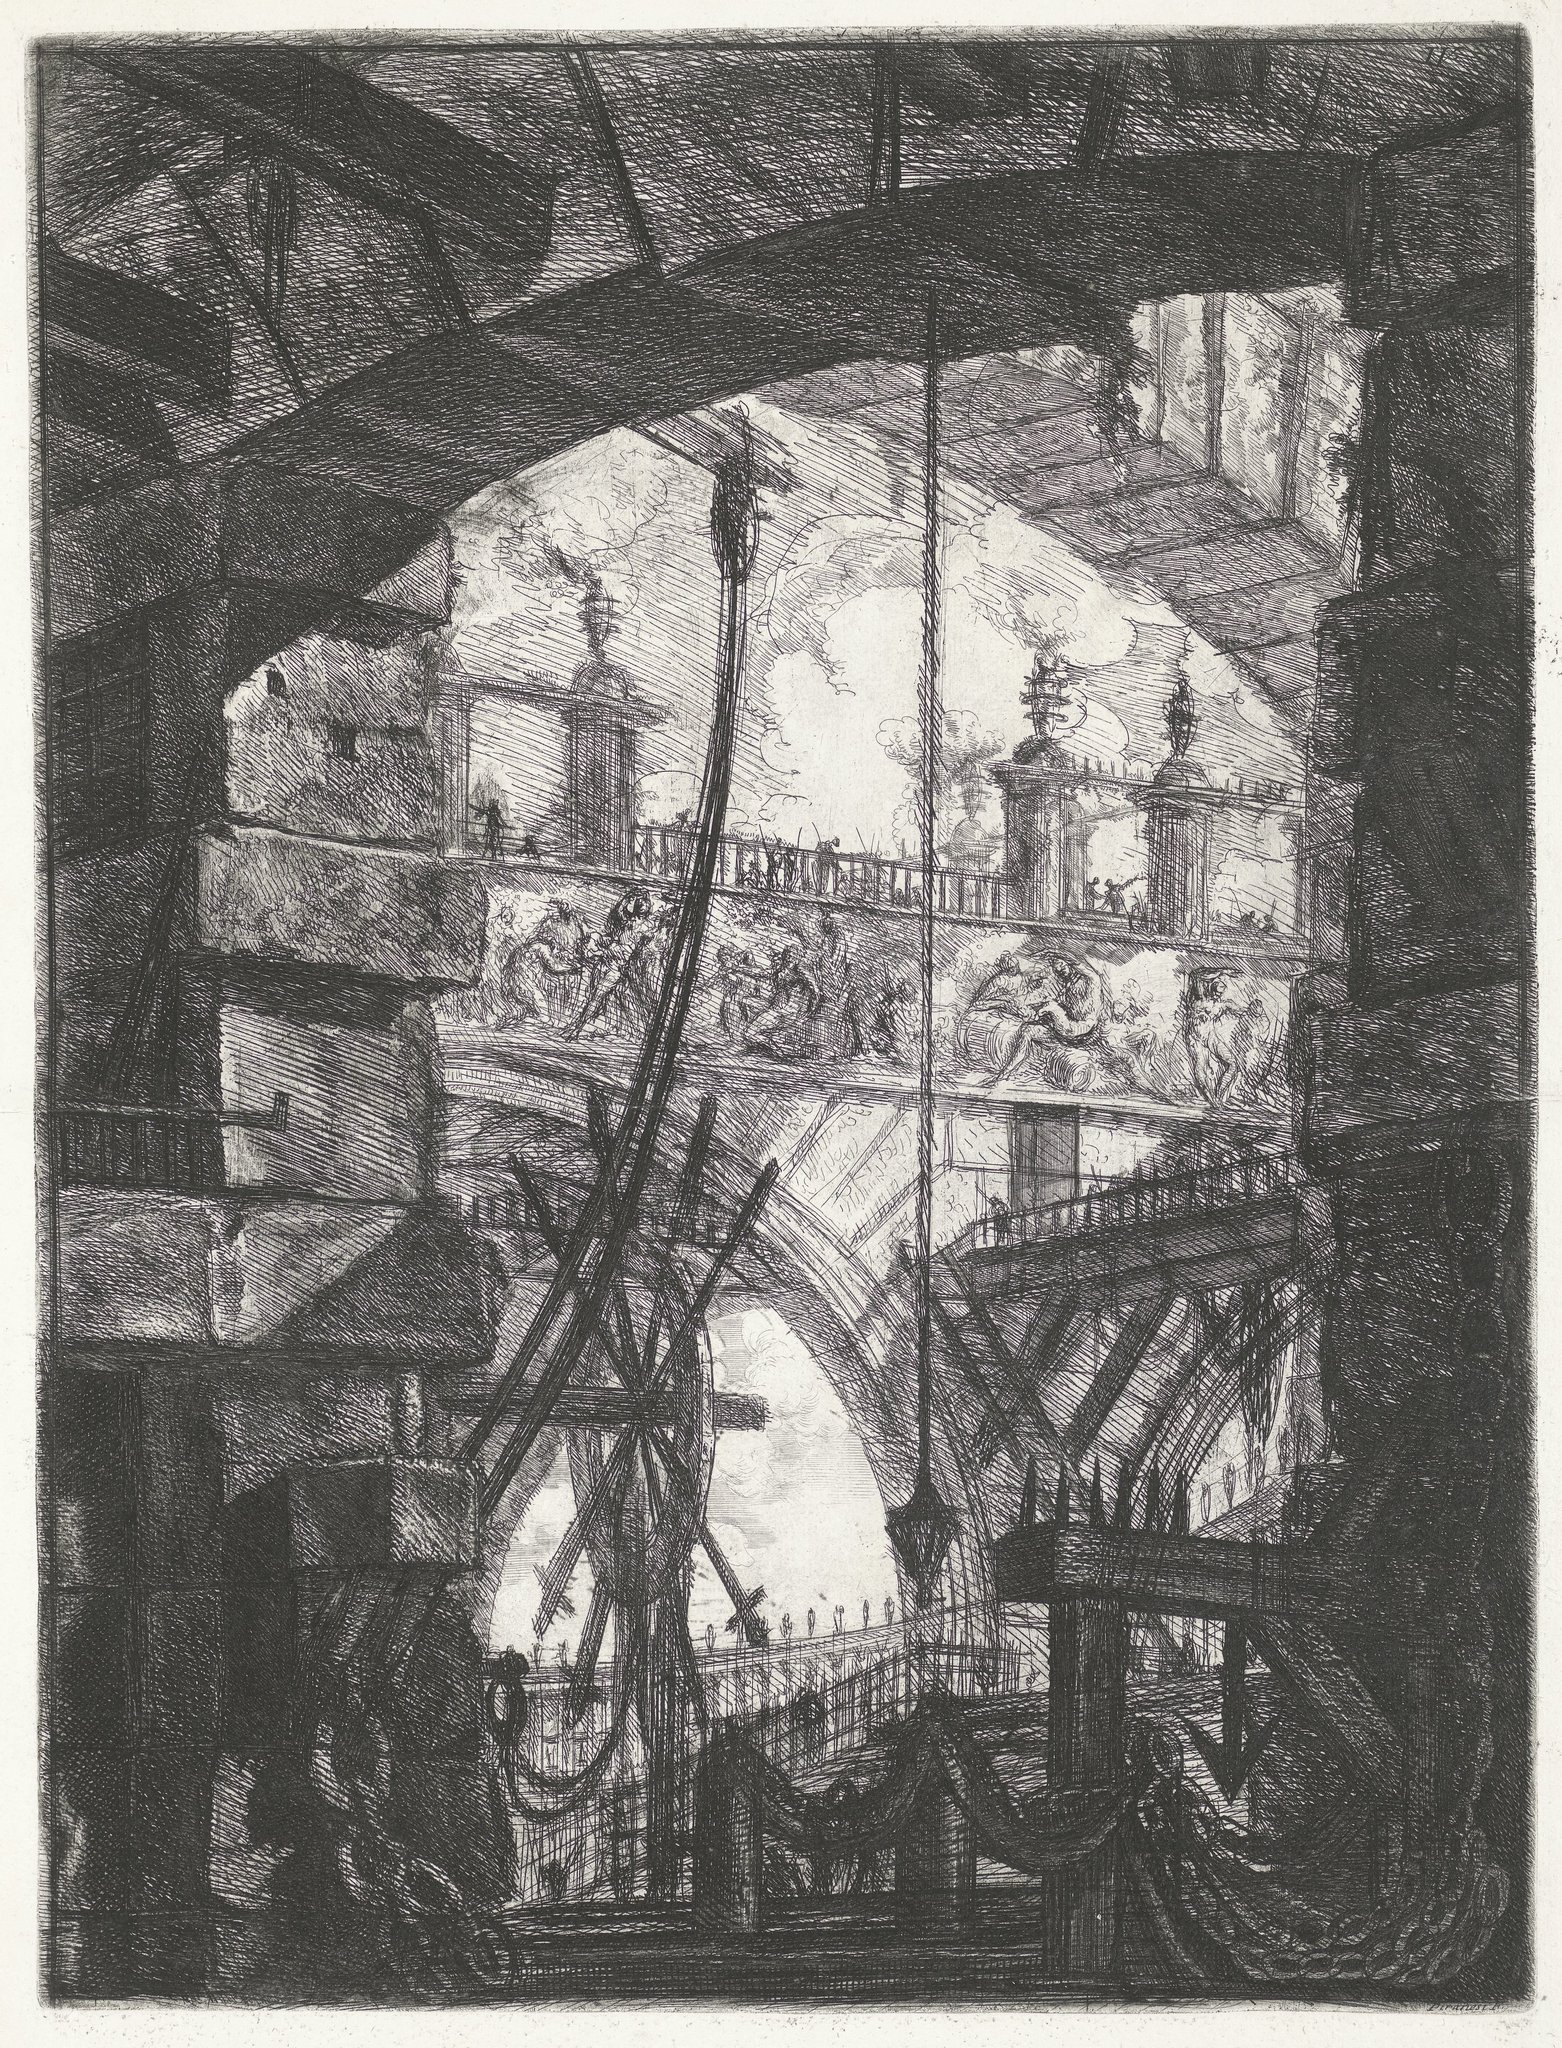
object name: print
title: Kerkers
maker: giovanni battista piranesi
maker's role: designer, draughtsman, print maker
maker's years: 1720-1778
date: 1761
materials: paper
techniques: engraving, etching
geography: rome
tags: prison, jail, piece of sculpture, reproduction of a piece of sculpture, arcade ~ architecture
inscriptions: collector's mark: Lugt 2228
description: Deze prent maakt deel uit van de tweede editie van de 'Carceri'-reeks door Giovanni Battista Piranesi. De 14 platen (inclusief titelprent) tellende eerste editie van de 'Carceri'-reeks werd uitgegeven door Giovanni Bouchard te Rome tussen 1749-1750. Deze eerste editie van de reeks droeg de titel: 'Invenzioni Capric di Carceri all Acqua Forte'. De tweede editie gaf Piranesi zelf uit in 1761. Voor deze uitgave bewerkte hij alle platen en voegde hij twee nieuwe platen toe. De serie kreeg de nieuwe titel: 'Carceri d'invenzione'.